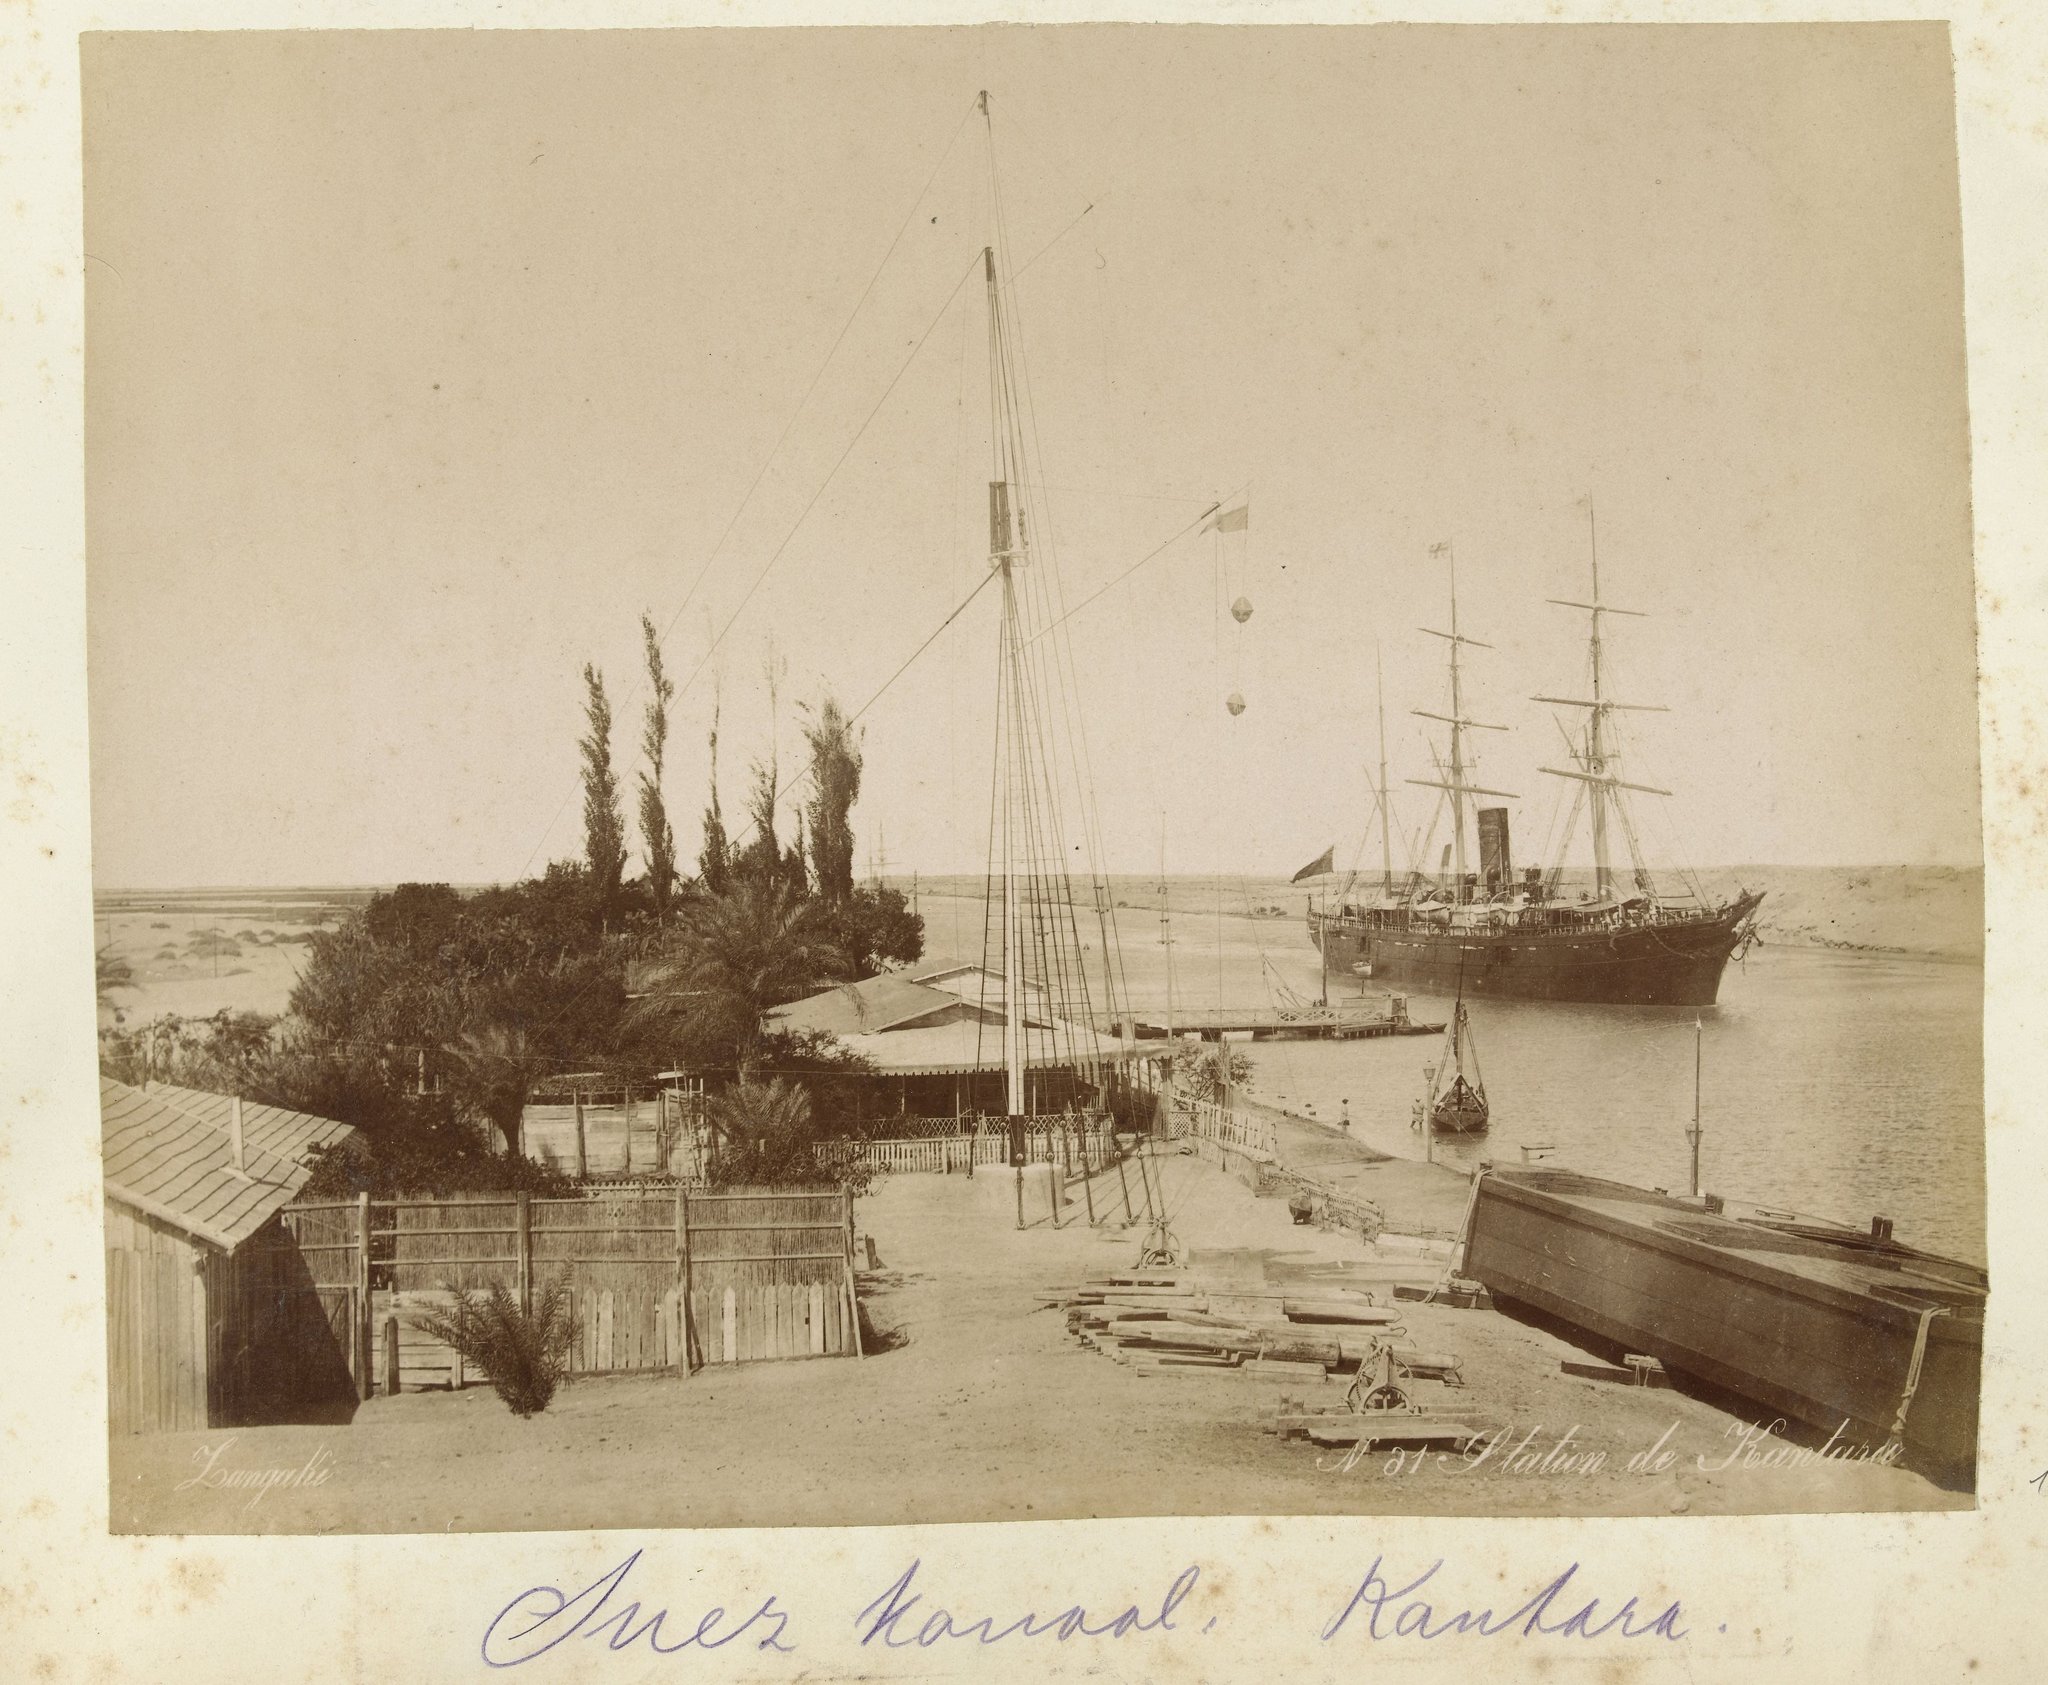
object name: photograph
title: No 61. Station de Kantara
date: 1890-1910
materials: cardboard, paper, photographic support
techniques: gelatin silver print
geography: netherlands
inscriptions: caption: ‘Suez kanaal, Kantara’, title: ‘No 61. Station de Kantara’